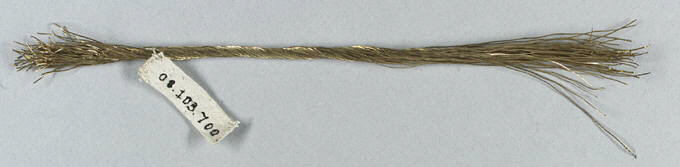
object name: cord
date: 1601-1800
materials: metal thread